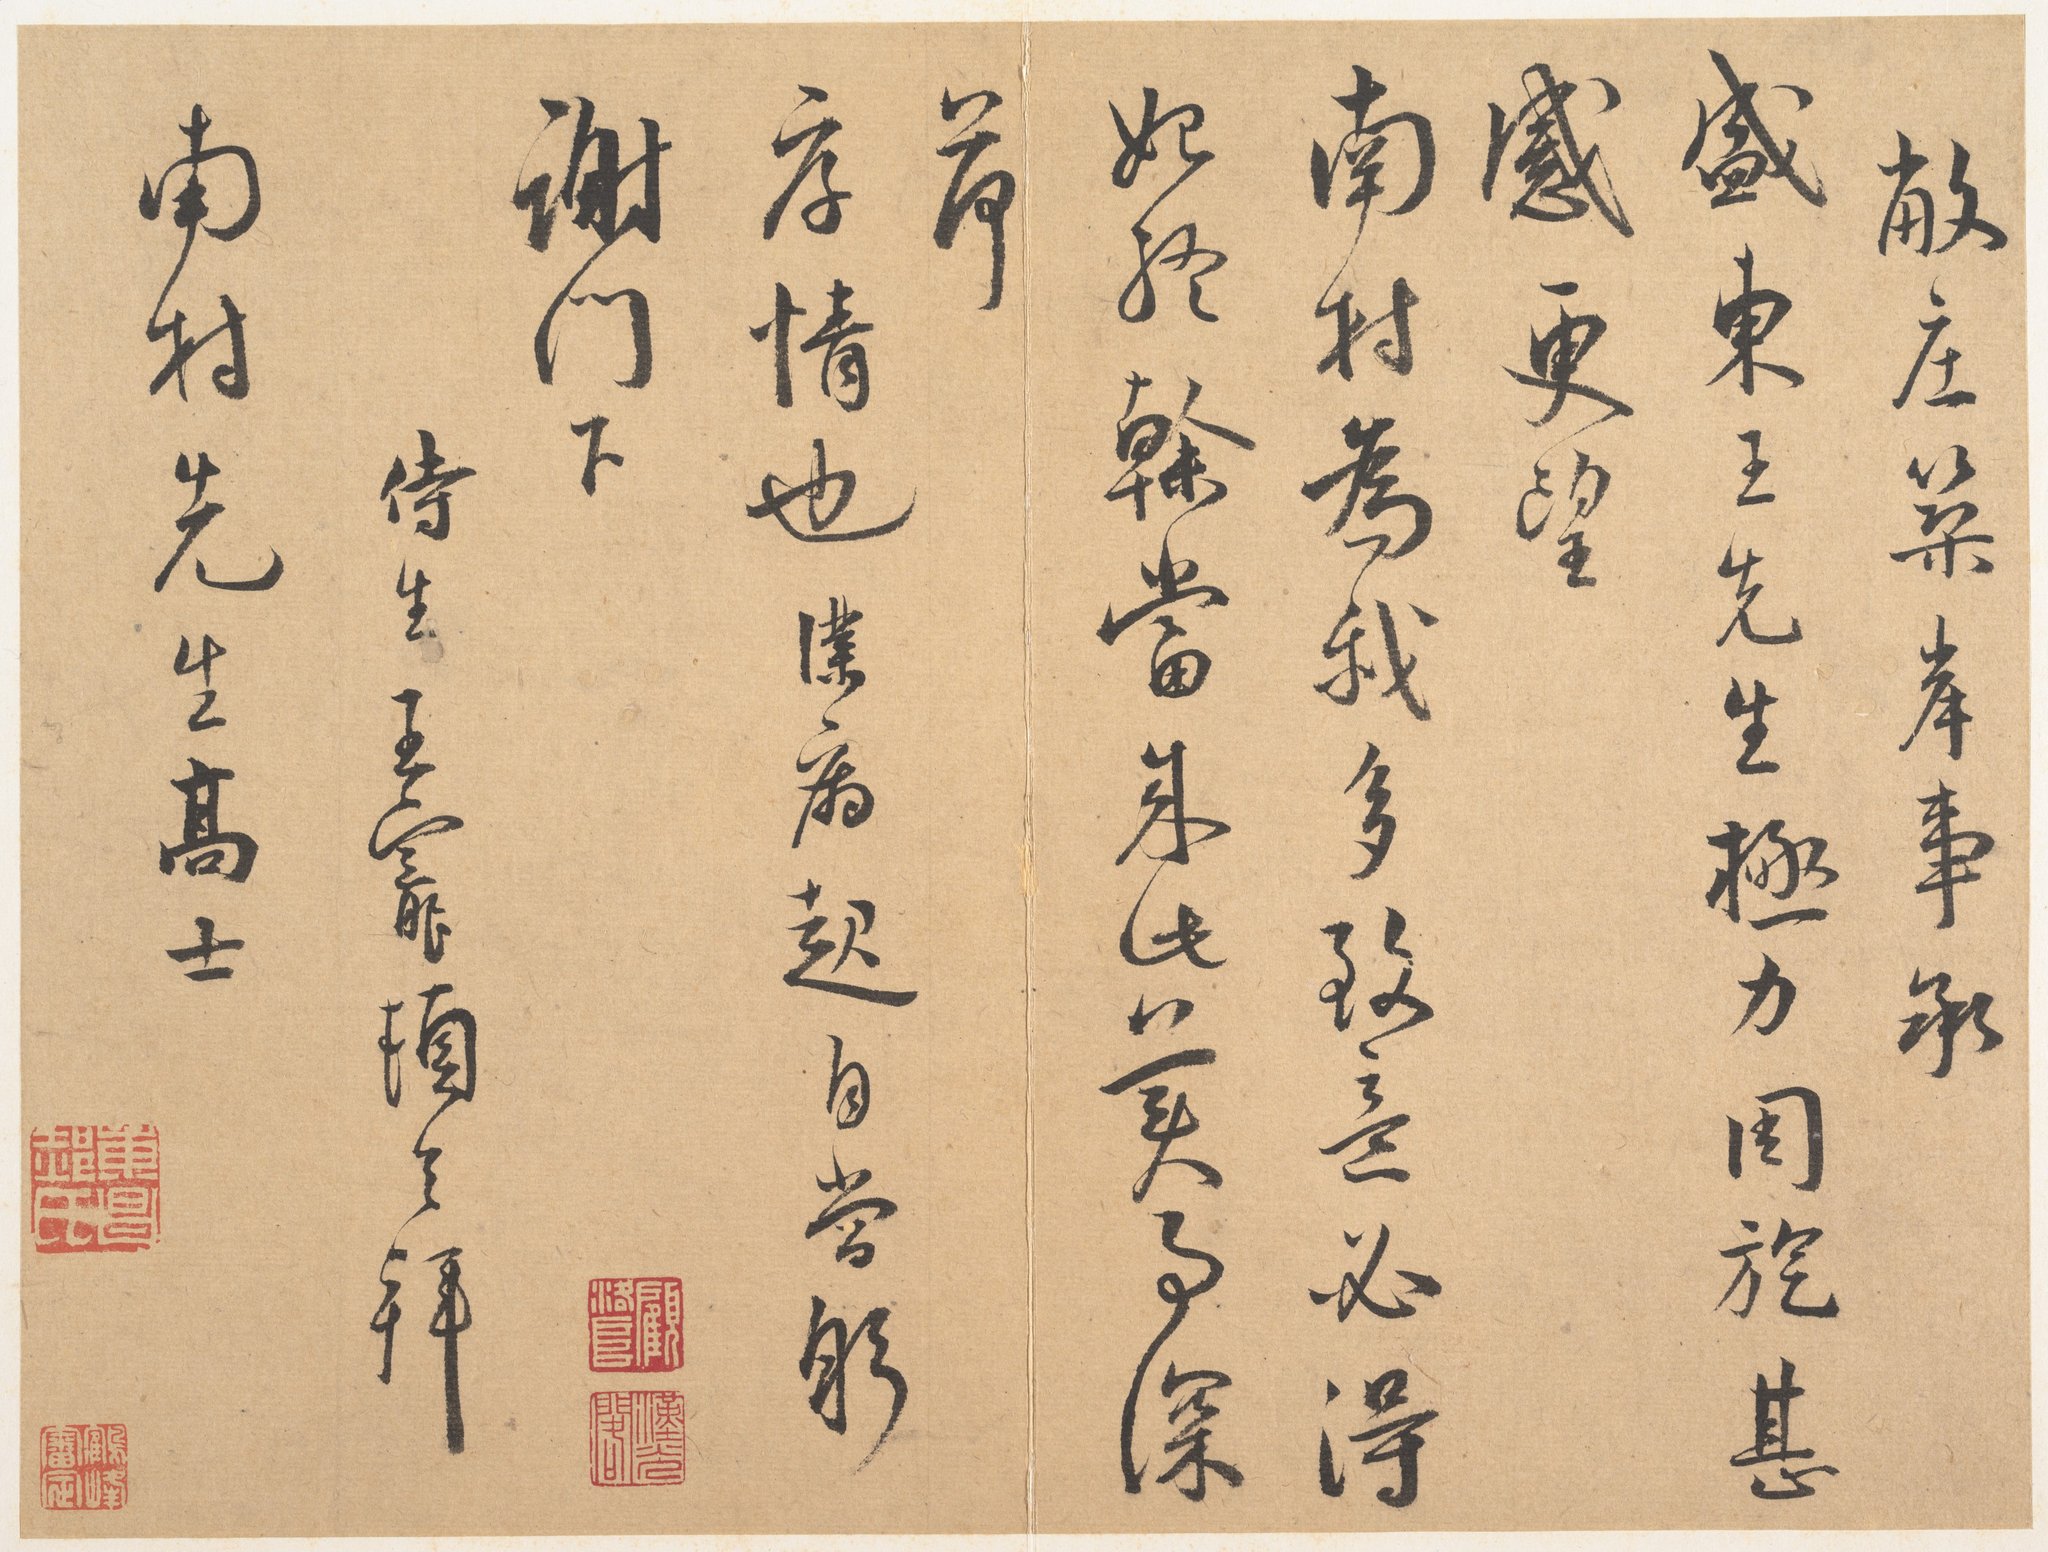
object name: album leaf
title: Letter to Nancun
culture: chinese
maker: wang chong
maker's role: artist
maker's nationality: chinese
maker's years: 1494-1533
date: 1494-1533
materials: ink, paper